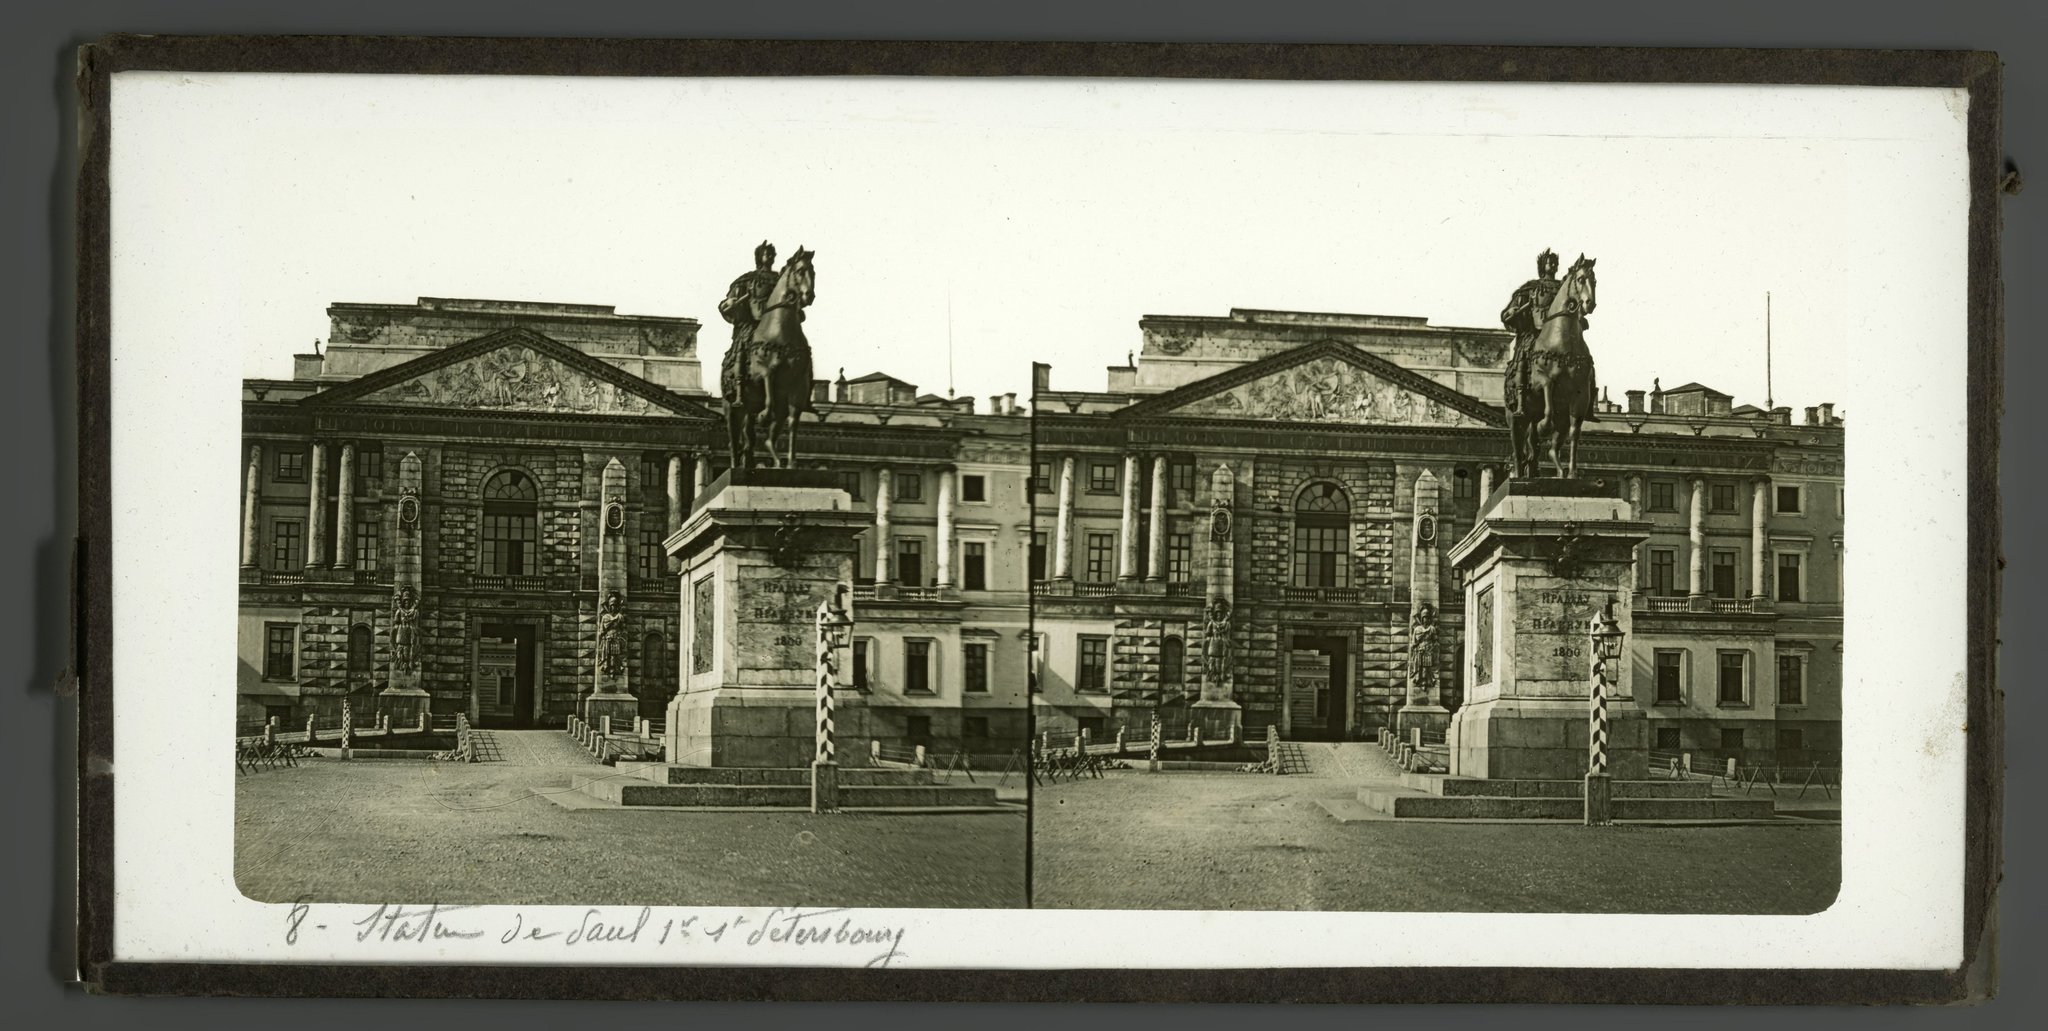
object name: photograph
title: Ruiterstandbeeld van Peter de Grote voor het Michailovski-kasteel in Sint-Petersburg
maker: Anonymous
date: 1860-1890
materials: glass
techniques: slide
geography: sint-petersburg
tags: monument, statue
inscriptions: number: ‘8’